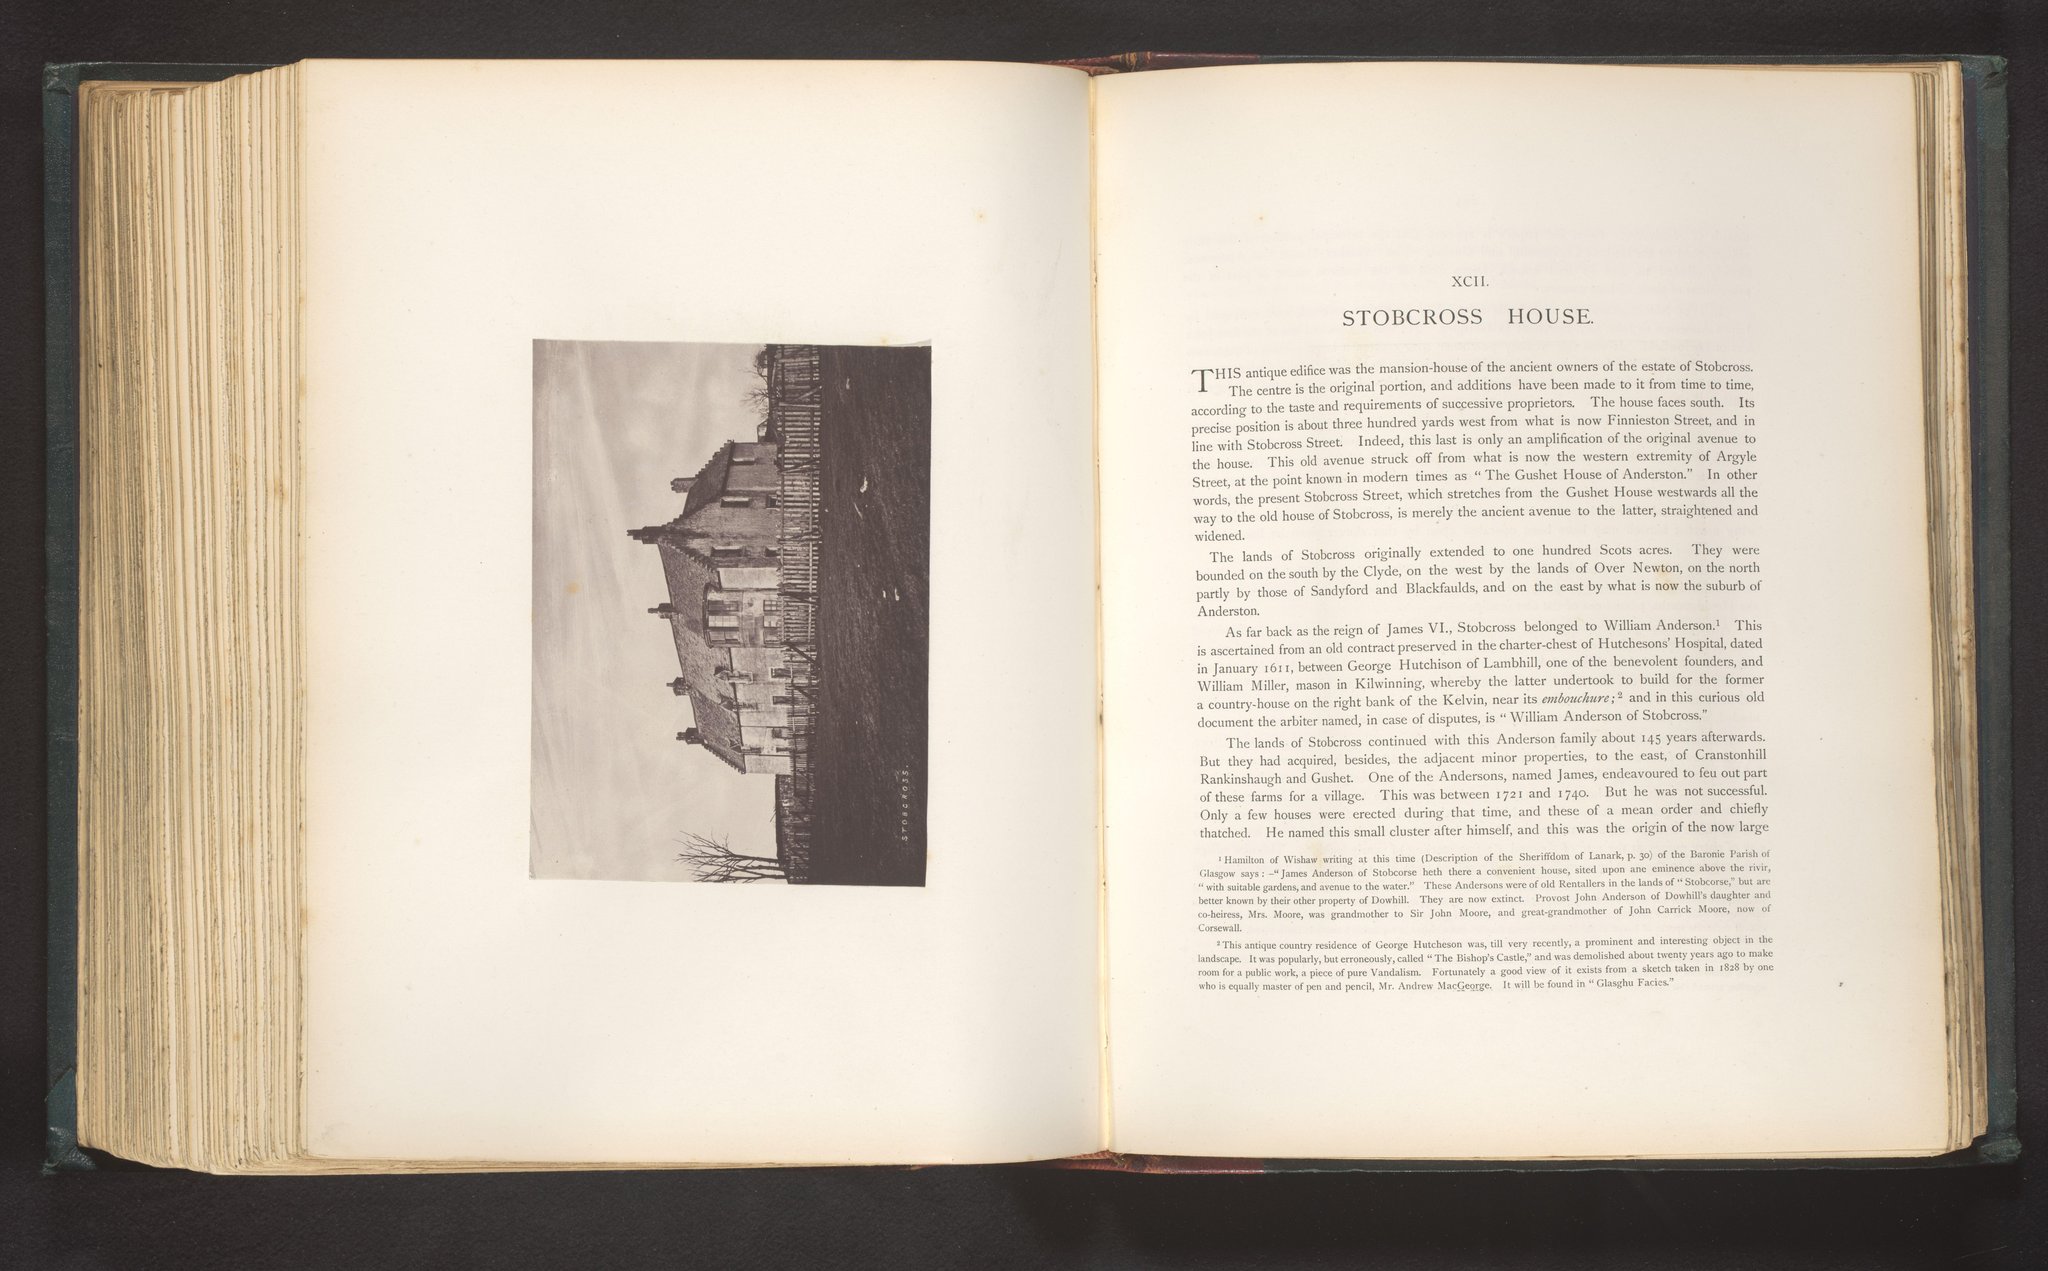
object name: page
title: Stobcross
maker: thomas annan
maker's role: fotograaf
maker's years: 1829-1887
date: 1868-1878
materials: paper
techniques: carbon print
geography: glasgow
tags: rural housing, e.g. country-house, villa, cottage, façade (of house or building)